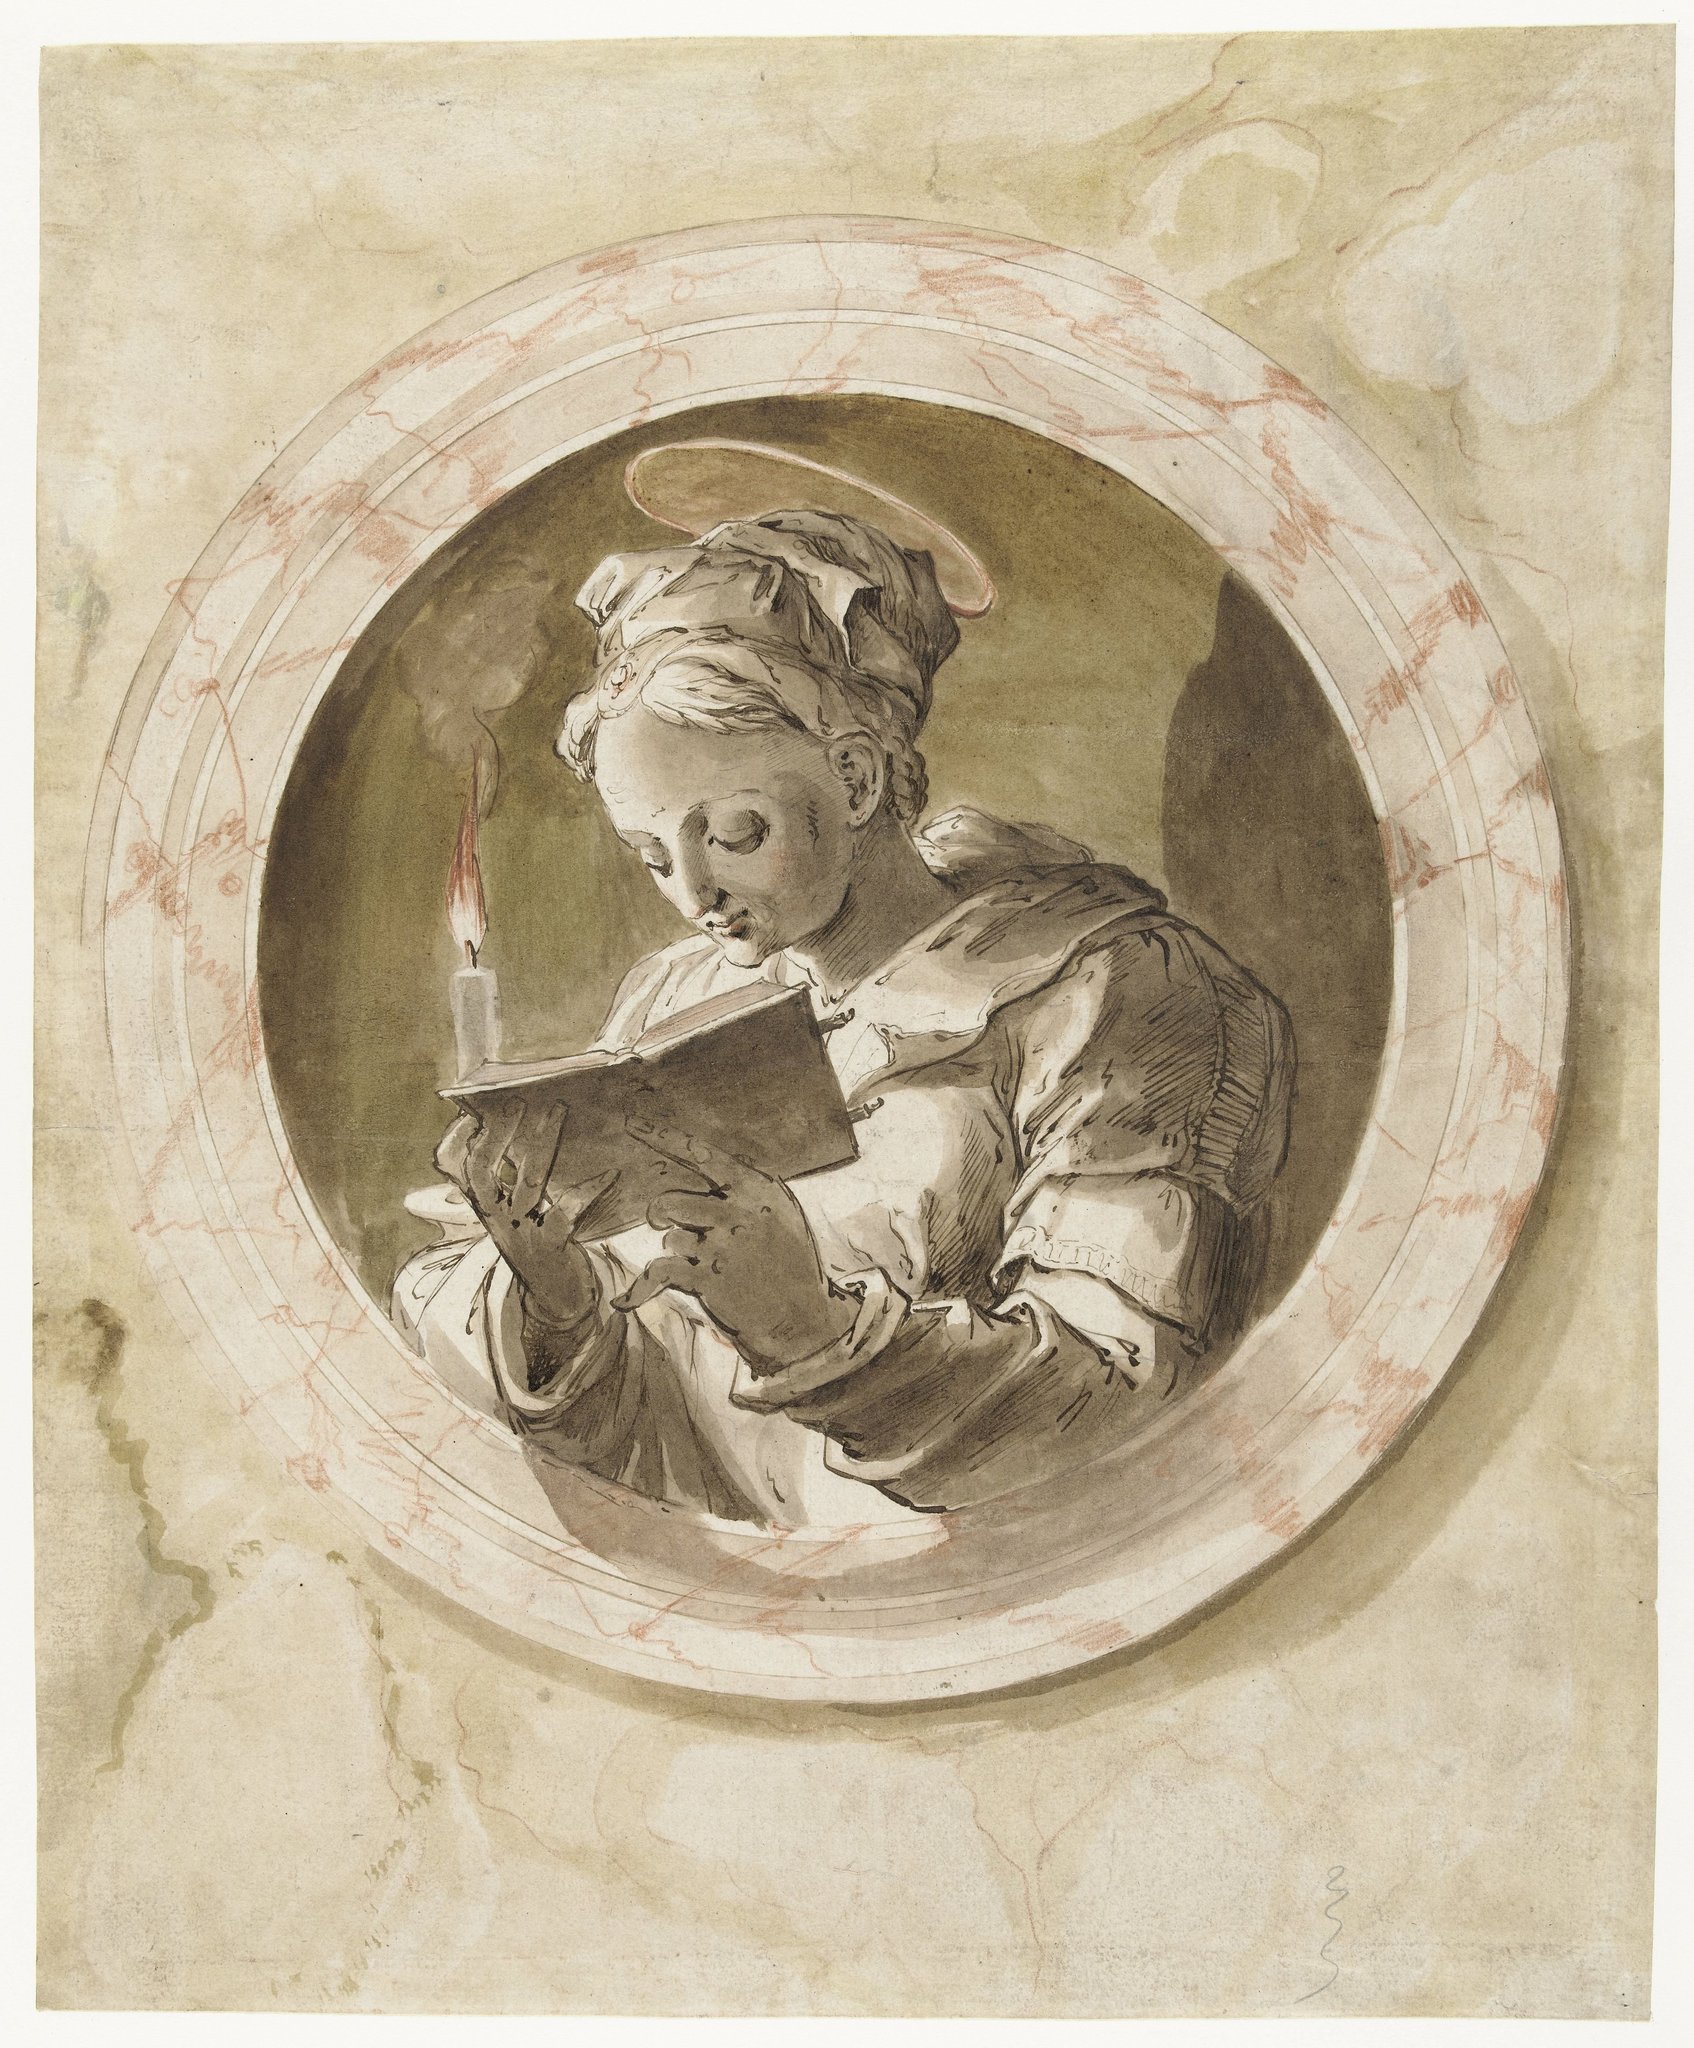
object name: drawing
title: Maria Magdalena of de heilige Agatha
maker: joos van winghe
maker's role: draughtsman, painter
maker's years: 1544-1603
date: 1587-1603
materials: chalk, ink, paper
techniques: brush, pen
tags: the penitent harlot mary magdalene; possible attributes: book (or scroll), crown, crown of thorns, crucifix, jar of ointment, mirror, musical instrument, palm-branch, rosary, scourge